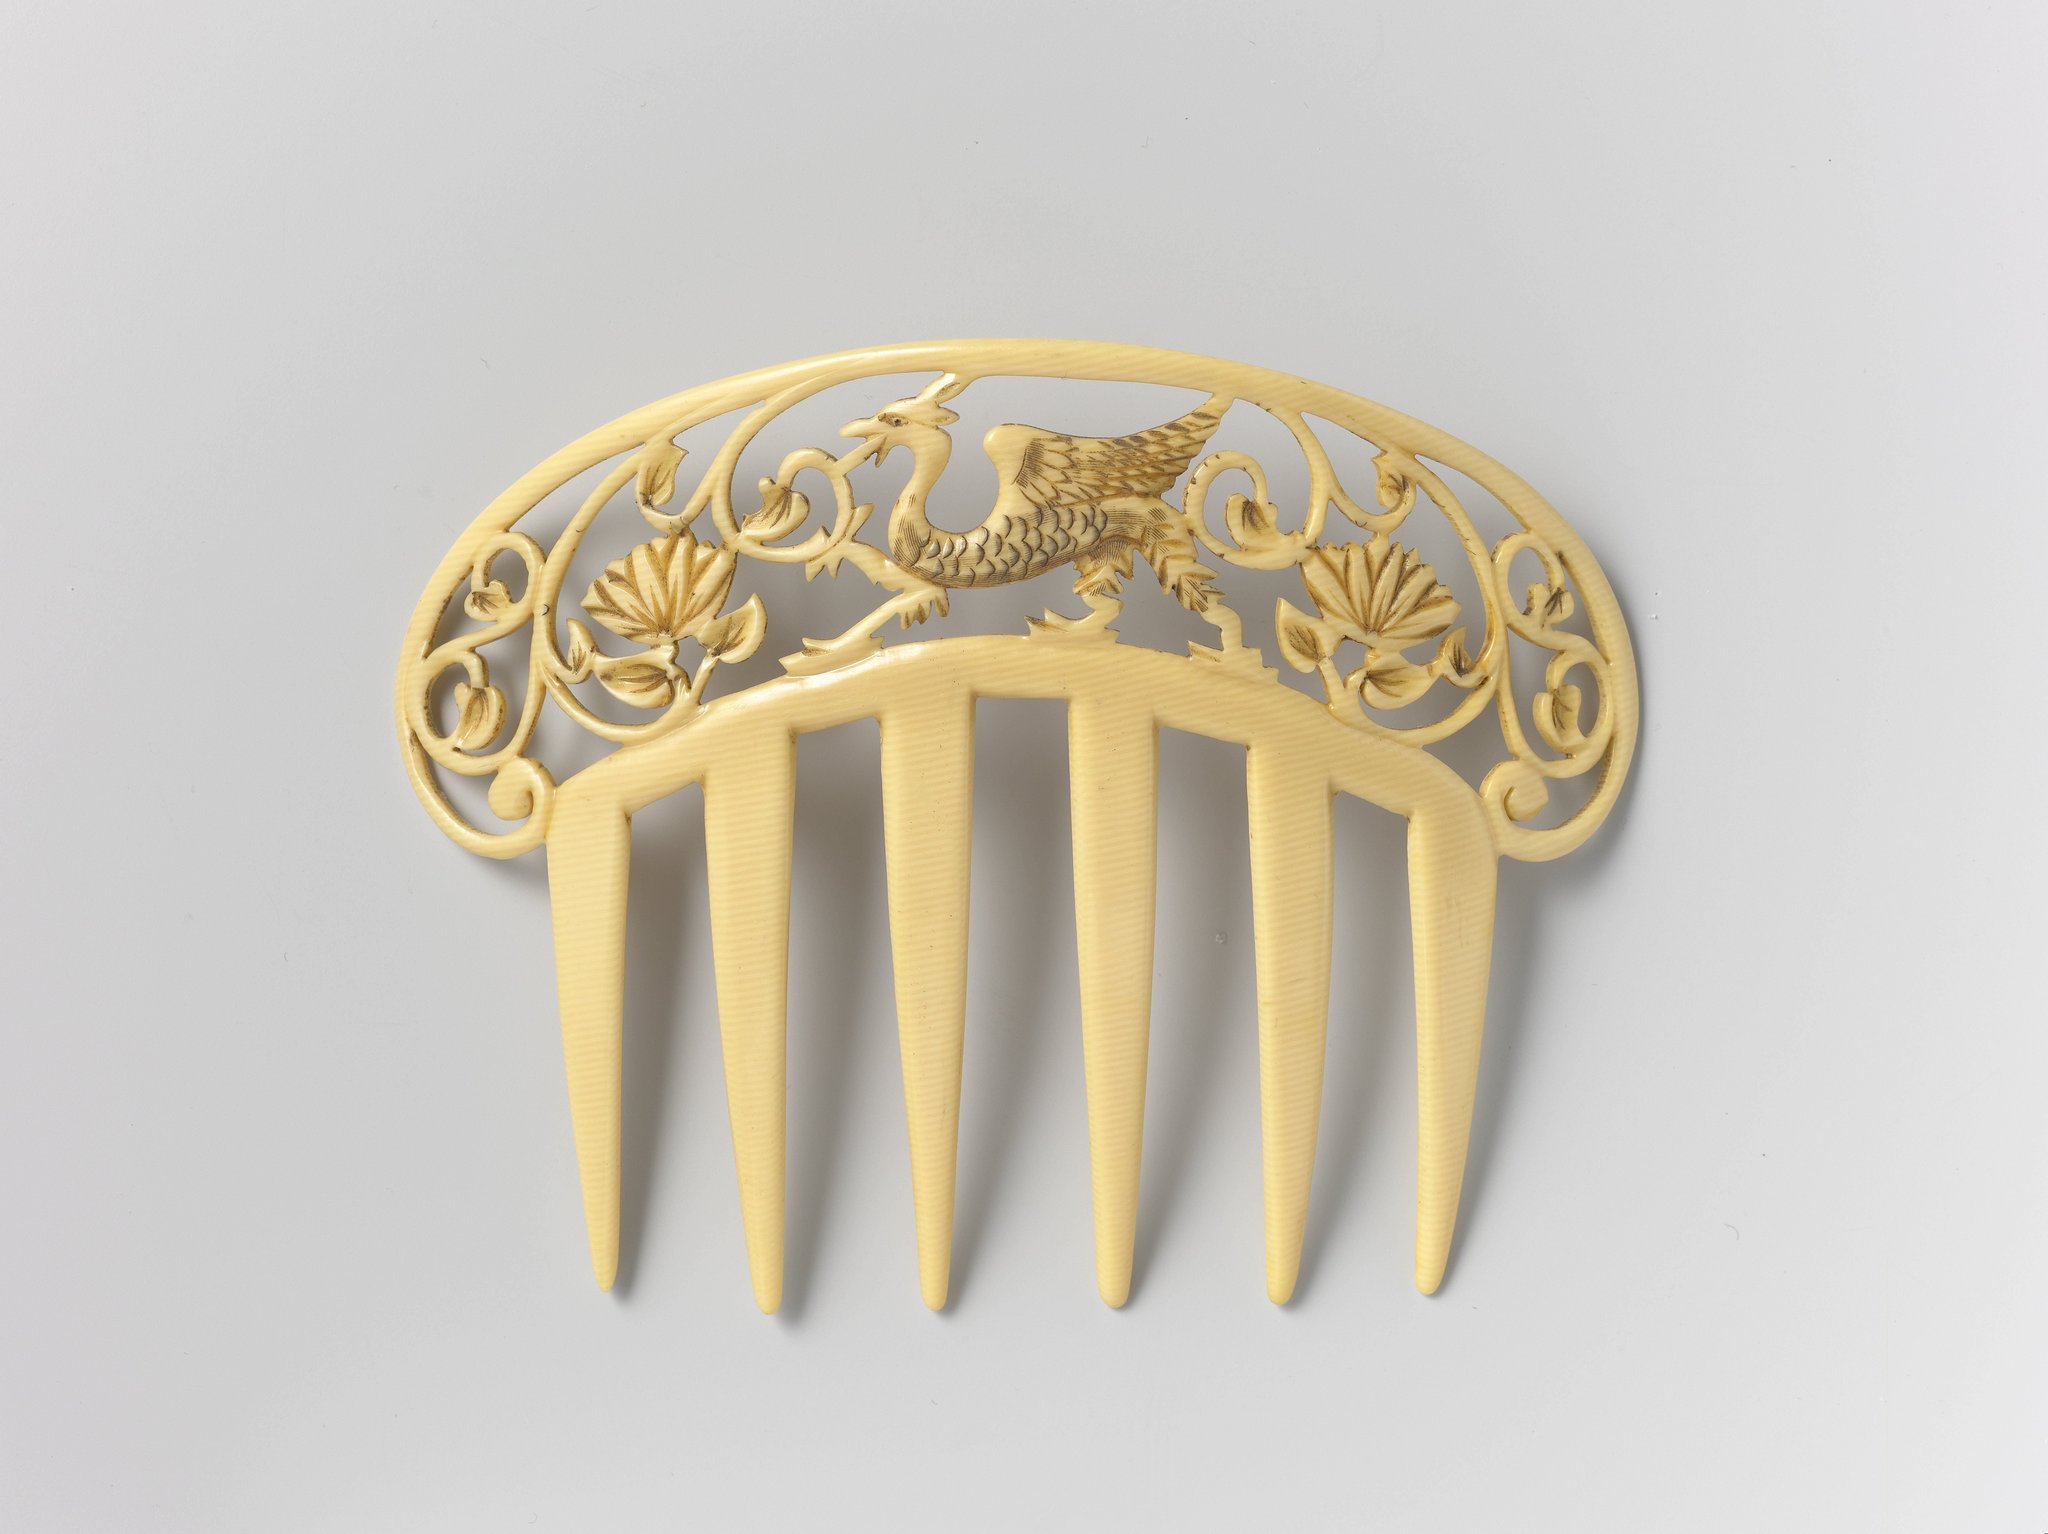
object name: comb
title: Haarkam van galalith met half ronde rug met een ajour gesneden draak in het midden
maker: Anonymous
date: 1925-1930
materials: plastic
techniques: embroidery, filing, polish, pressing, sawing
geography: netherlands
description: Haarkam van galalith met half ronde rug, waarop een ajour gesneden draak in het midden met aan beide kanten een lotusachtige bloem. Zes tanden.